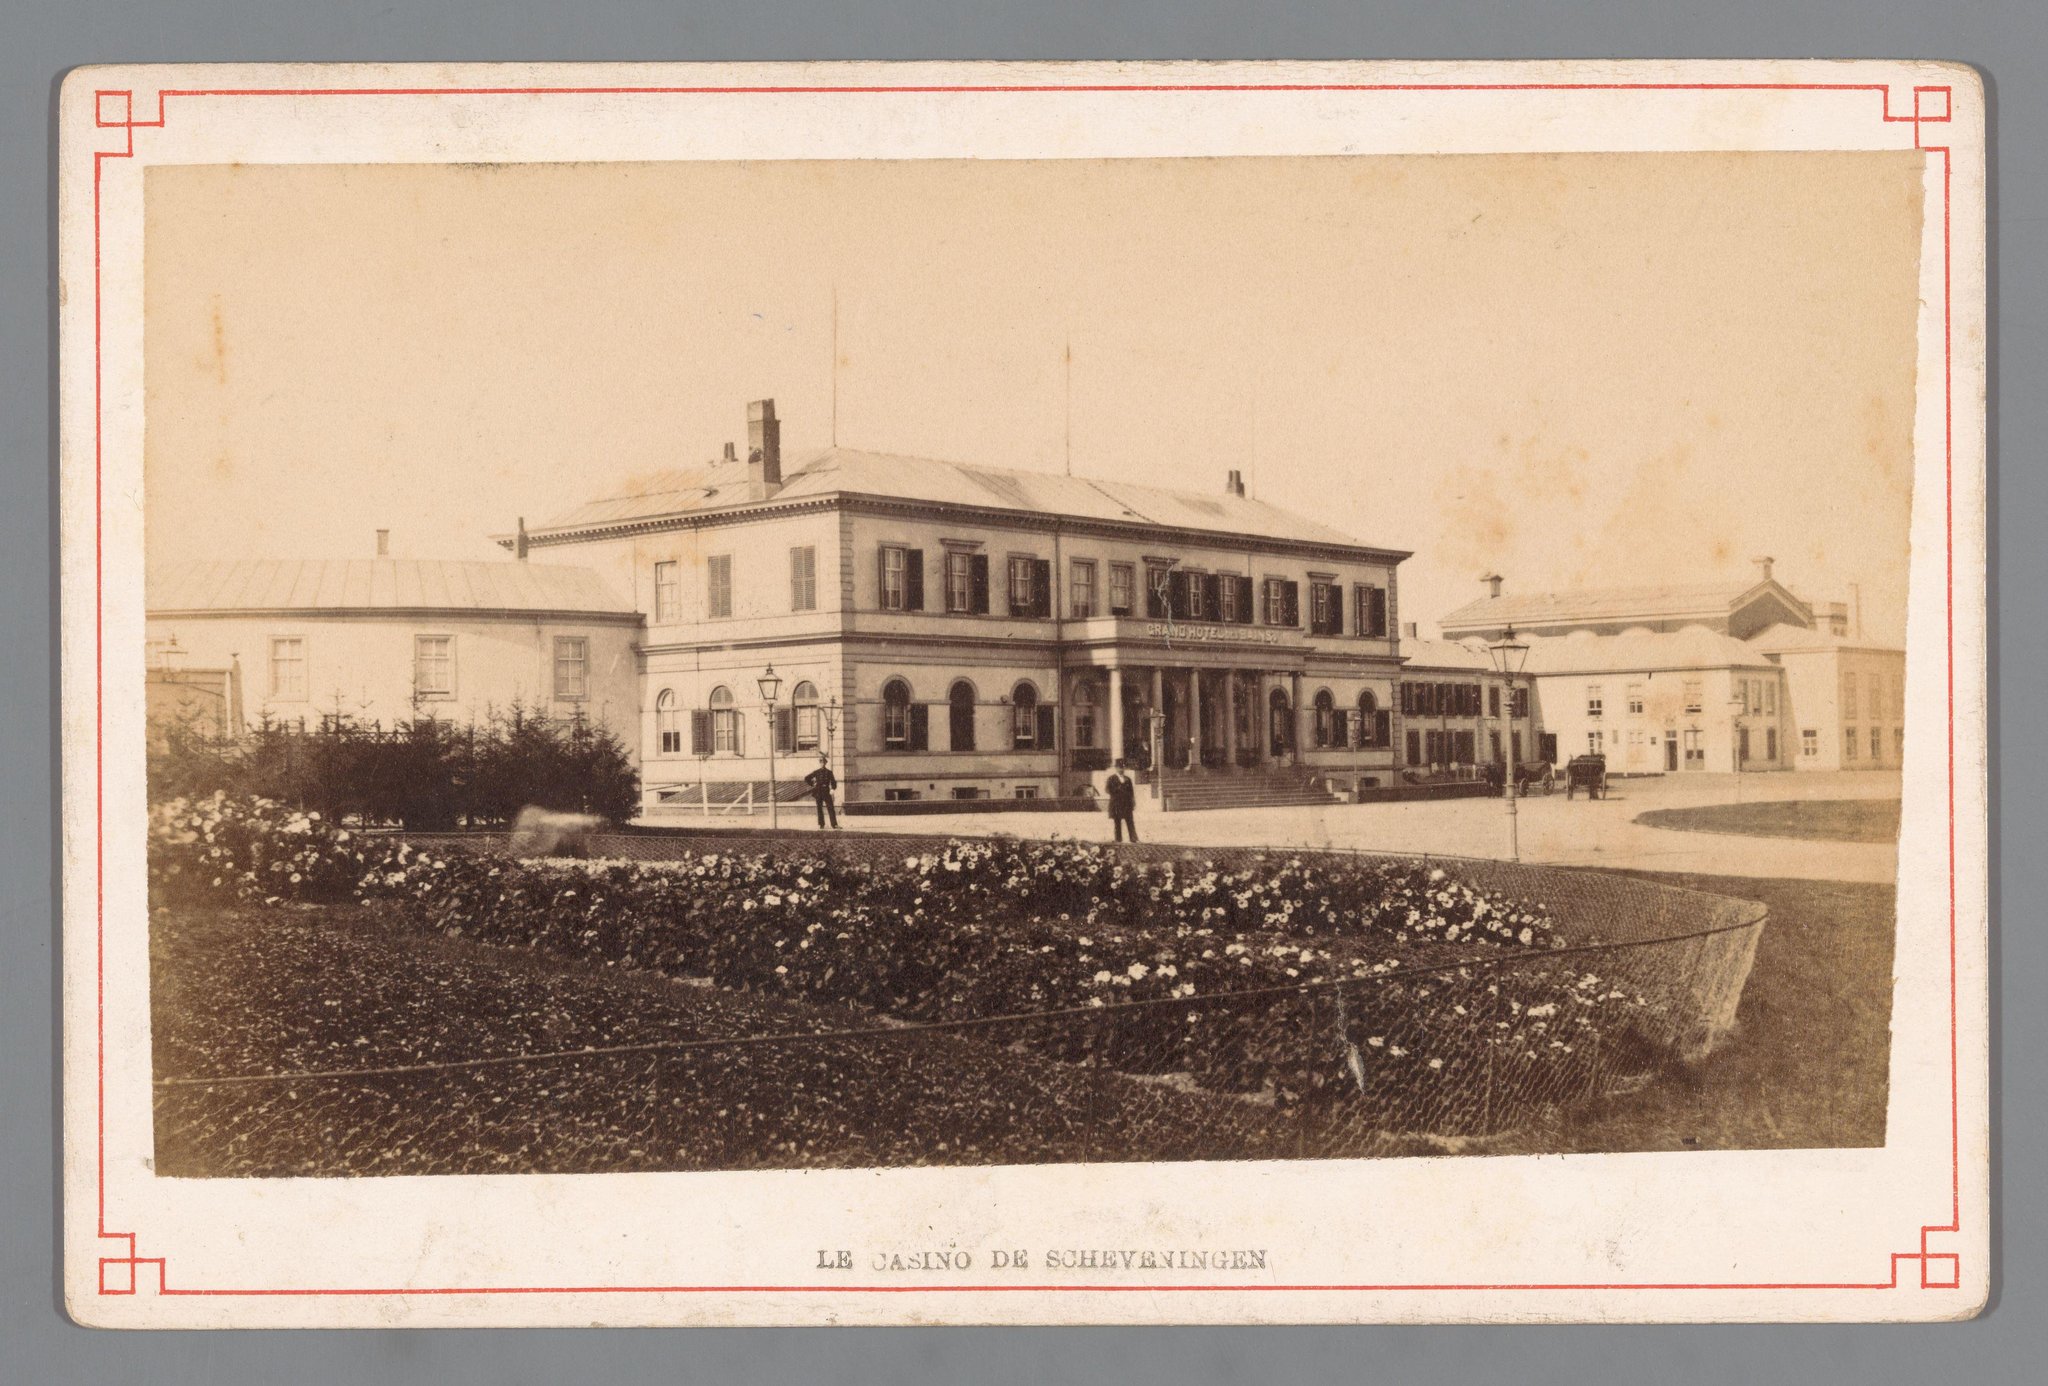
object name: photograph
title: Le casino de Scheveningen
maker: Anonymous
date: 1870-1884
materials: cardboard, photographic support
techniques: albumen print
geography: scheveningen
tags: public baths, façade (of house or building)